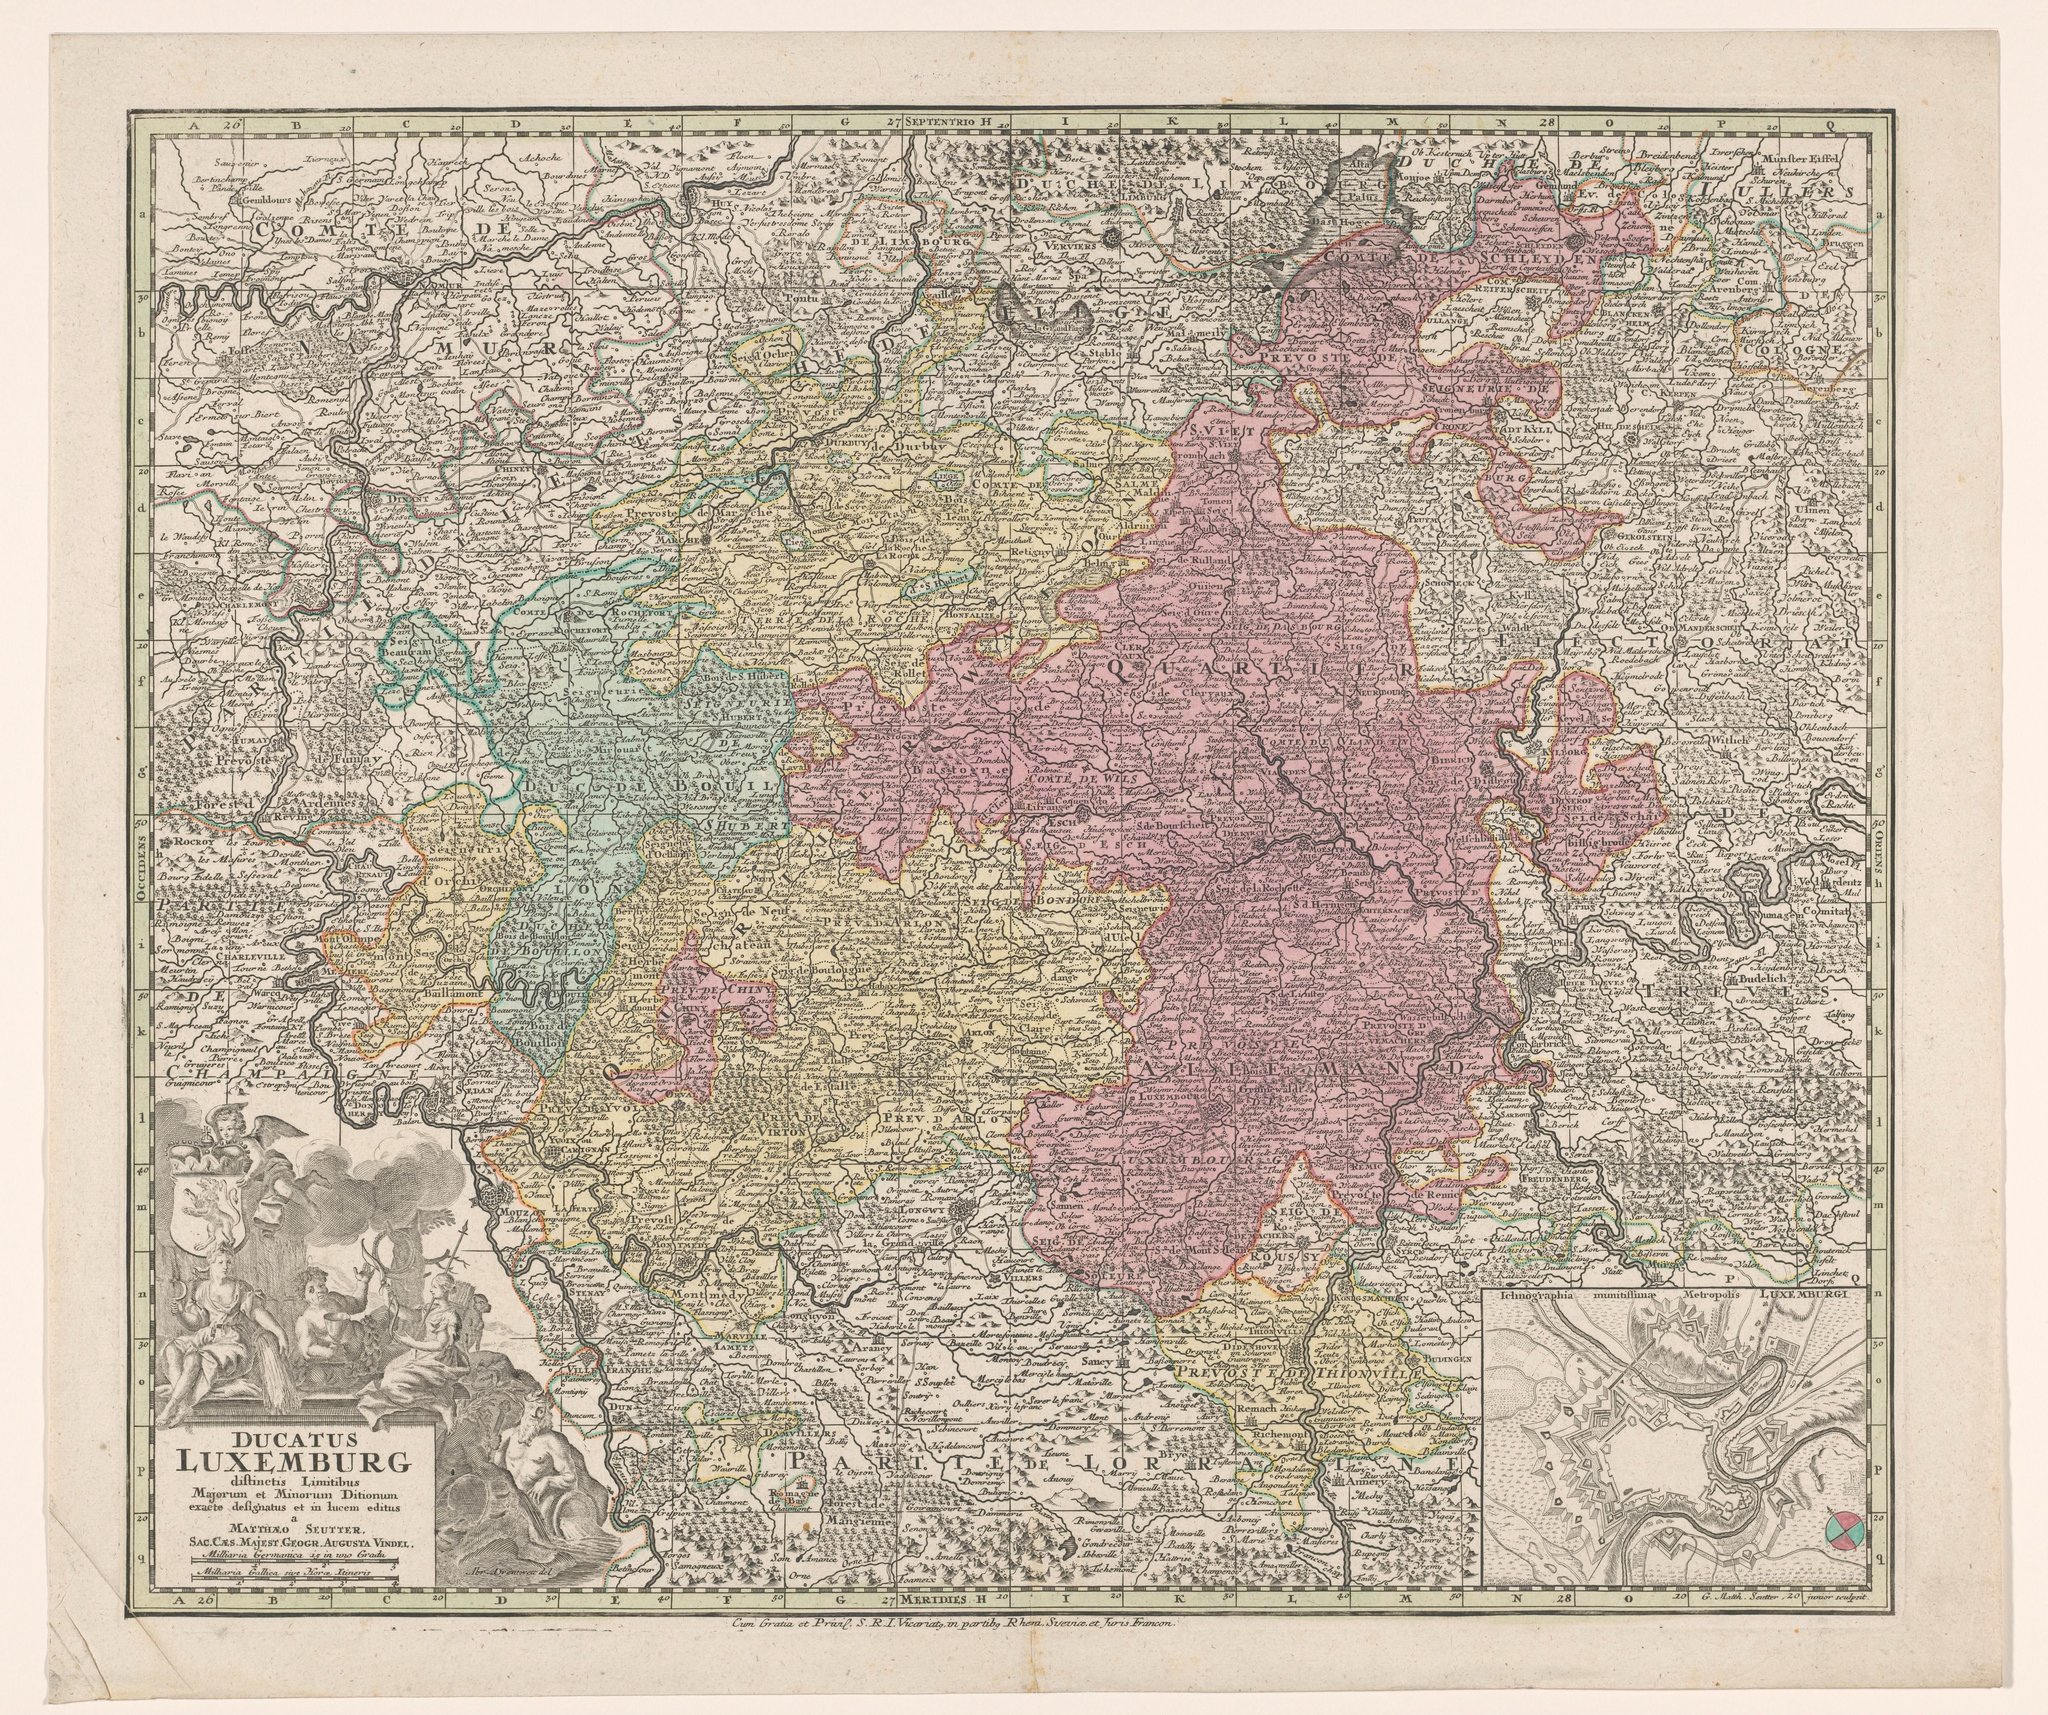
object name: map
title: Kaart van Luxemburg met een vestingplattegrond van de stad Luxemburg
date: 1730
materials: paper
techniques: engraving, etching, hand coloring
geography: augsburg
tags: maps of separate countries or regions, maps of cities, coat of arms (as symbol of the state, etc.) (+ province; provincial)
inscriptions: collector's mark: Lugt 2228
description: Kaart van Luxemburg. Linksonder de titelcartouche met boven het wapen van het hertogdom Luxemburg en onder twee schaalstokken: 3 Milliaria Germanica 15 in uno Gradu / 4 Milliaria Gallica sive Horae Itineris. Rechtsonder een inzet met een vestingplattegrond van de stad Luxemburg. De kaart is voorzien van een zoekrooster en een gradenverdeling langs de randen.